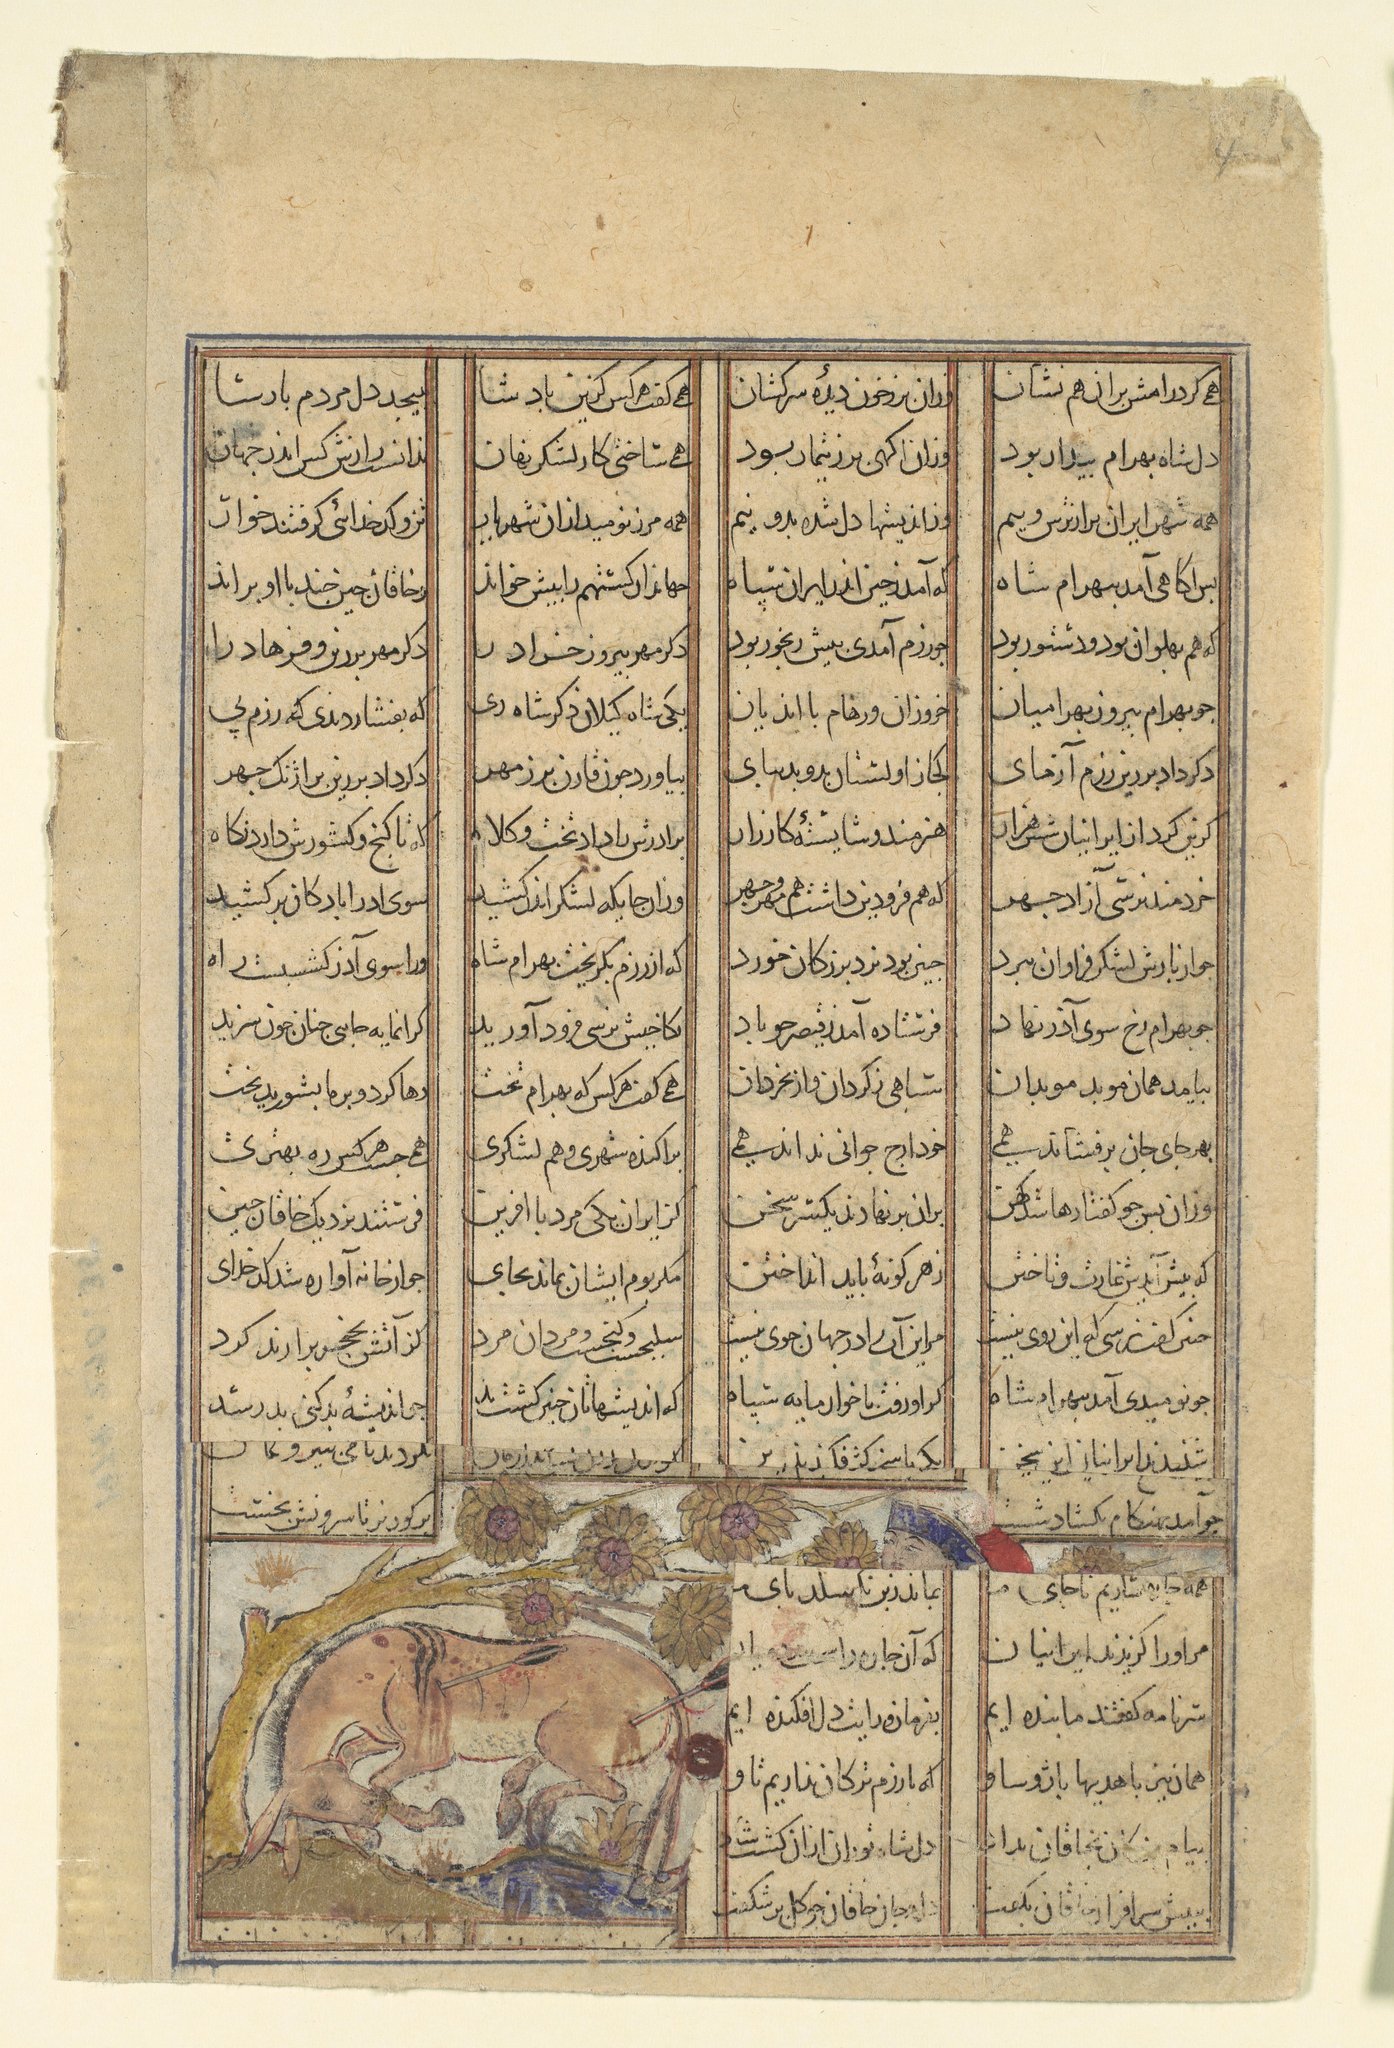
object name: folio from an illustrated manuscript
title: "Bahram Gur Hunts the Onager", Folio from a Shahnama (Book of Kings)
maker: abu'l qasim firdausi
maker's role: author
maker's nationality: iranian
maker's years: 935-1020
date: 1330-1340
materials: gold, ink, paper, silver, watercolor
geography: iran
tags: animals,men,hunting